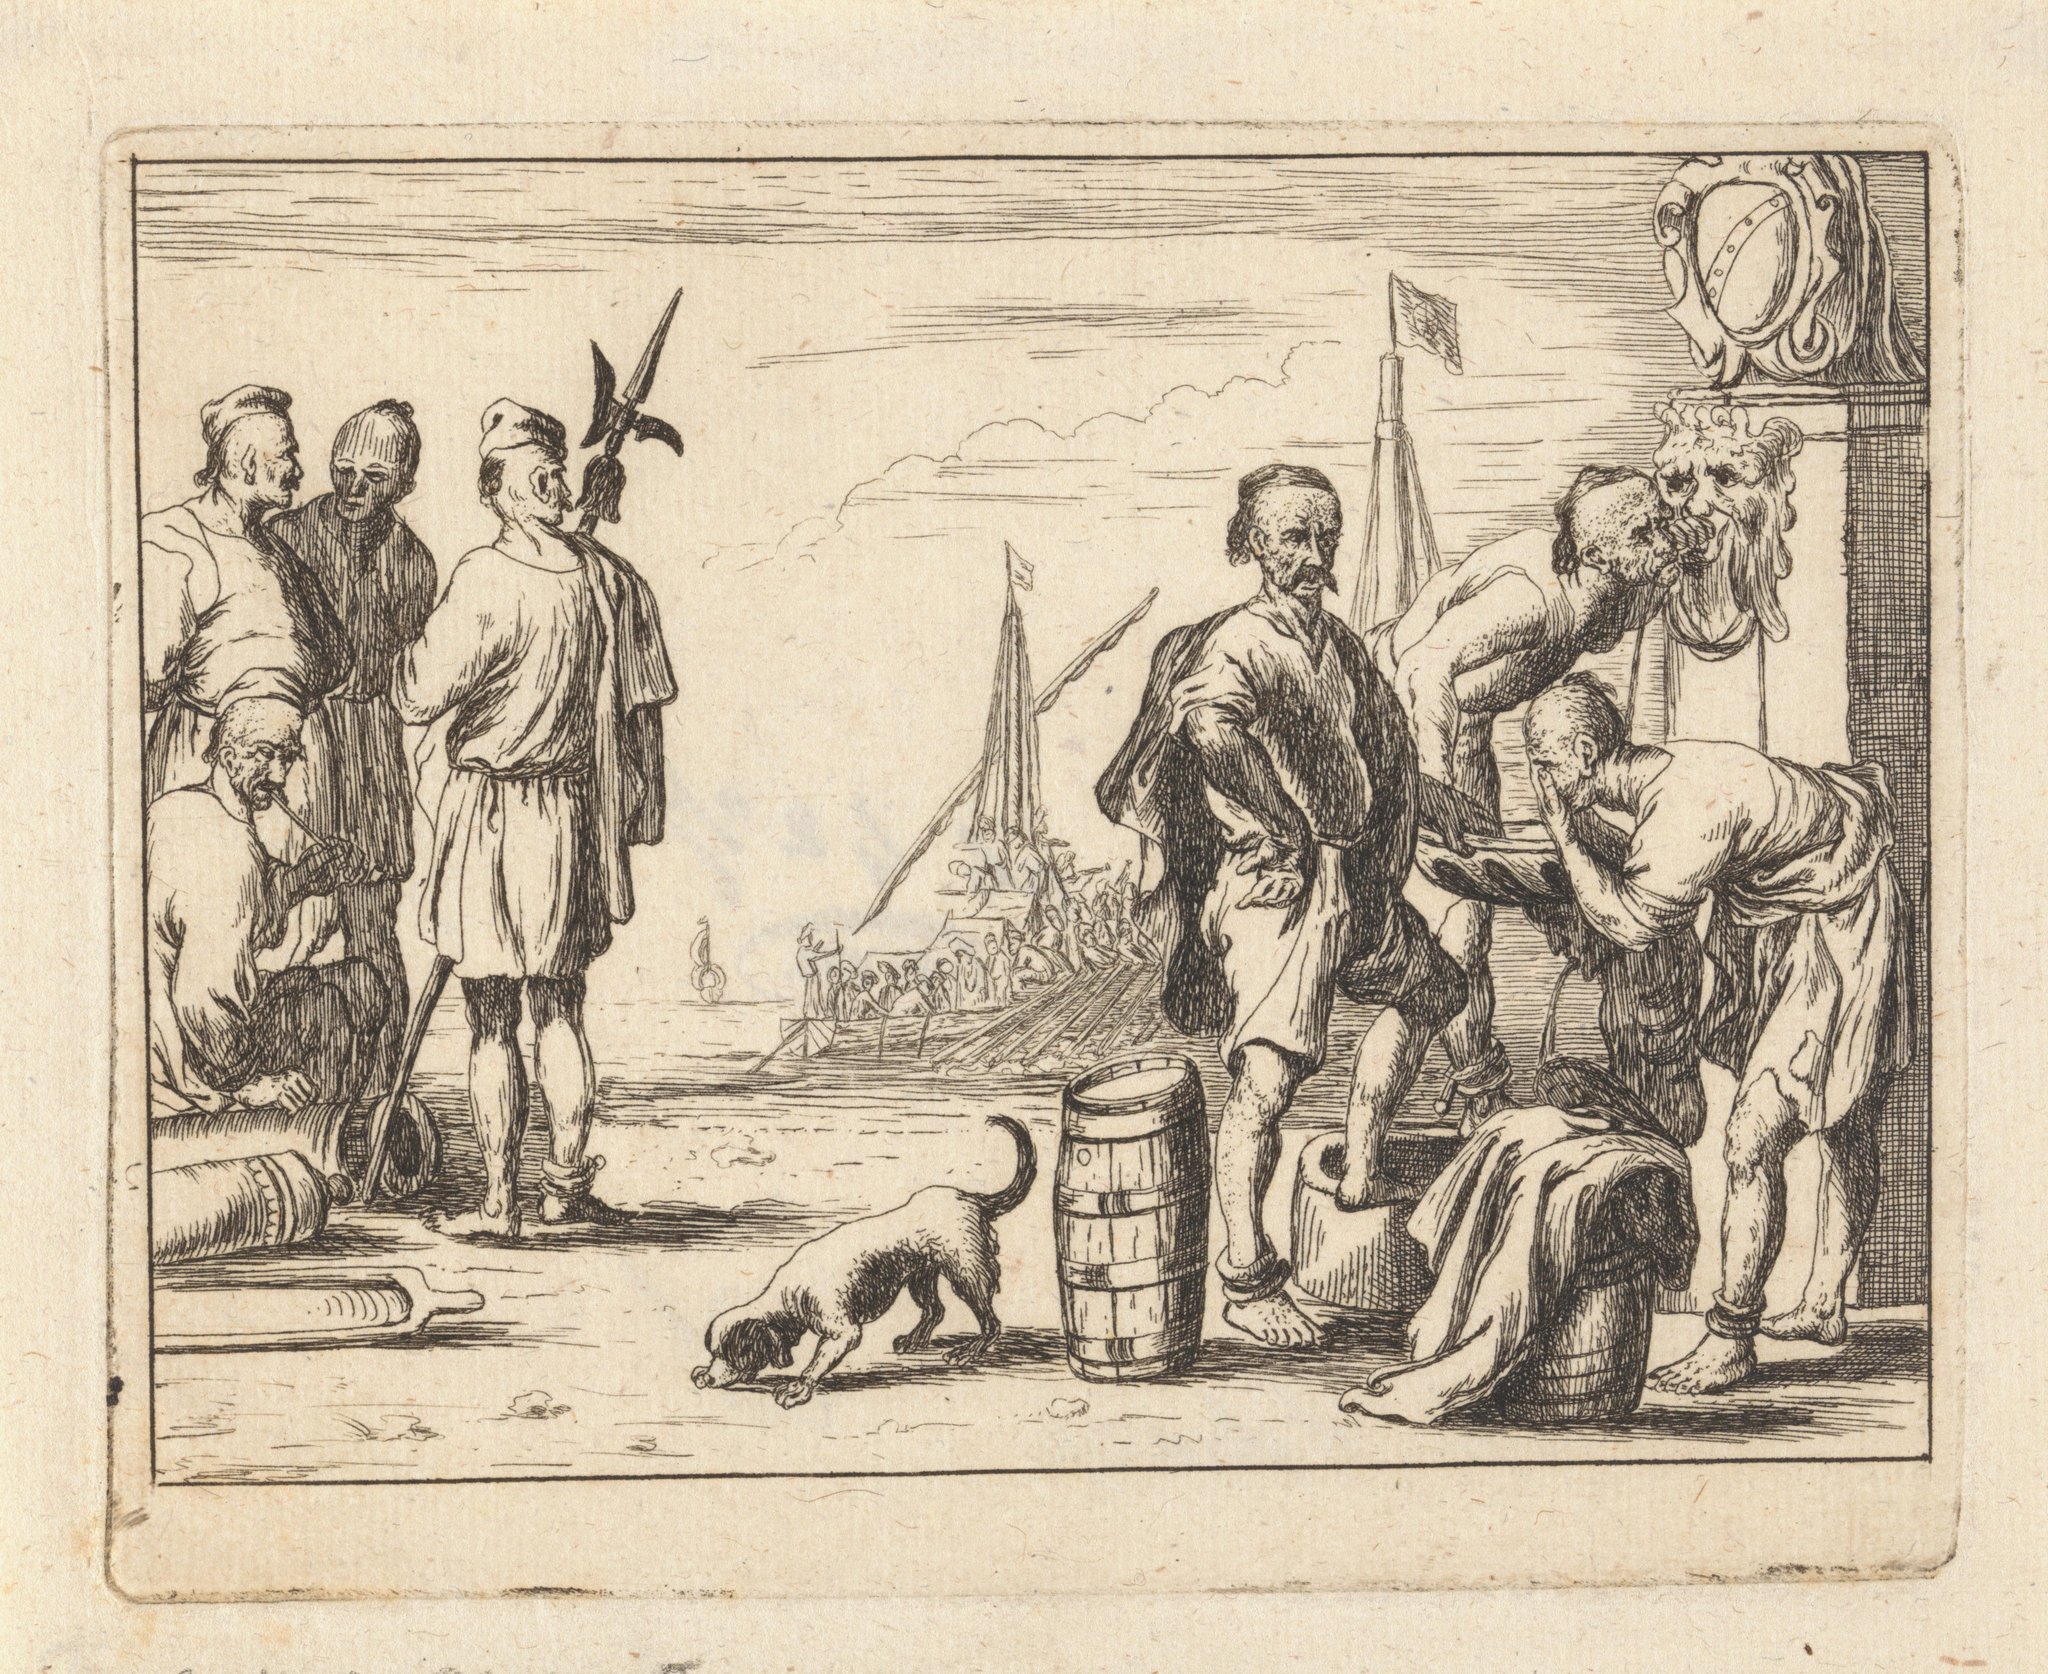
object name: print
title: Haventaferelen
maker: m. schaep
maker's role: print maker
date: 1649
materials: paper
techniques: etching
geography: northern netherlands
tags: harbour, trireme, galley (+ view ~ vehicle, ship, etc.), slavery; serfs and enslaved persons, ornamental fountain, drinking, seaman: sailor, washing one's face and head, dog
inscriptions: collector's mark: Lugt 2228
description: Rechts staan drie islamitische galeislaven bij een fontein. Eén van hen drinkt uit de fontein en een tweede wast zijn gezicht. In het midden snuffelt een hond bij een houten ton. Links nog vier islamitische galeislaven, van wie één een pijp rookt en een ander een hellebaard vasthoudt. Deze tot slaaf gemaakte mannen zijn als moslims te herkennen door het typerende kapsel (hoofd op een pluk na kaalgeschoren) dat zij verplicht waren te hebben. Achter hen vaart een galei.